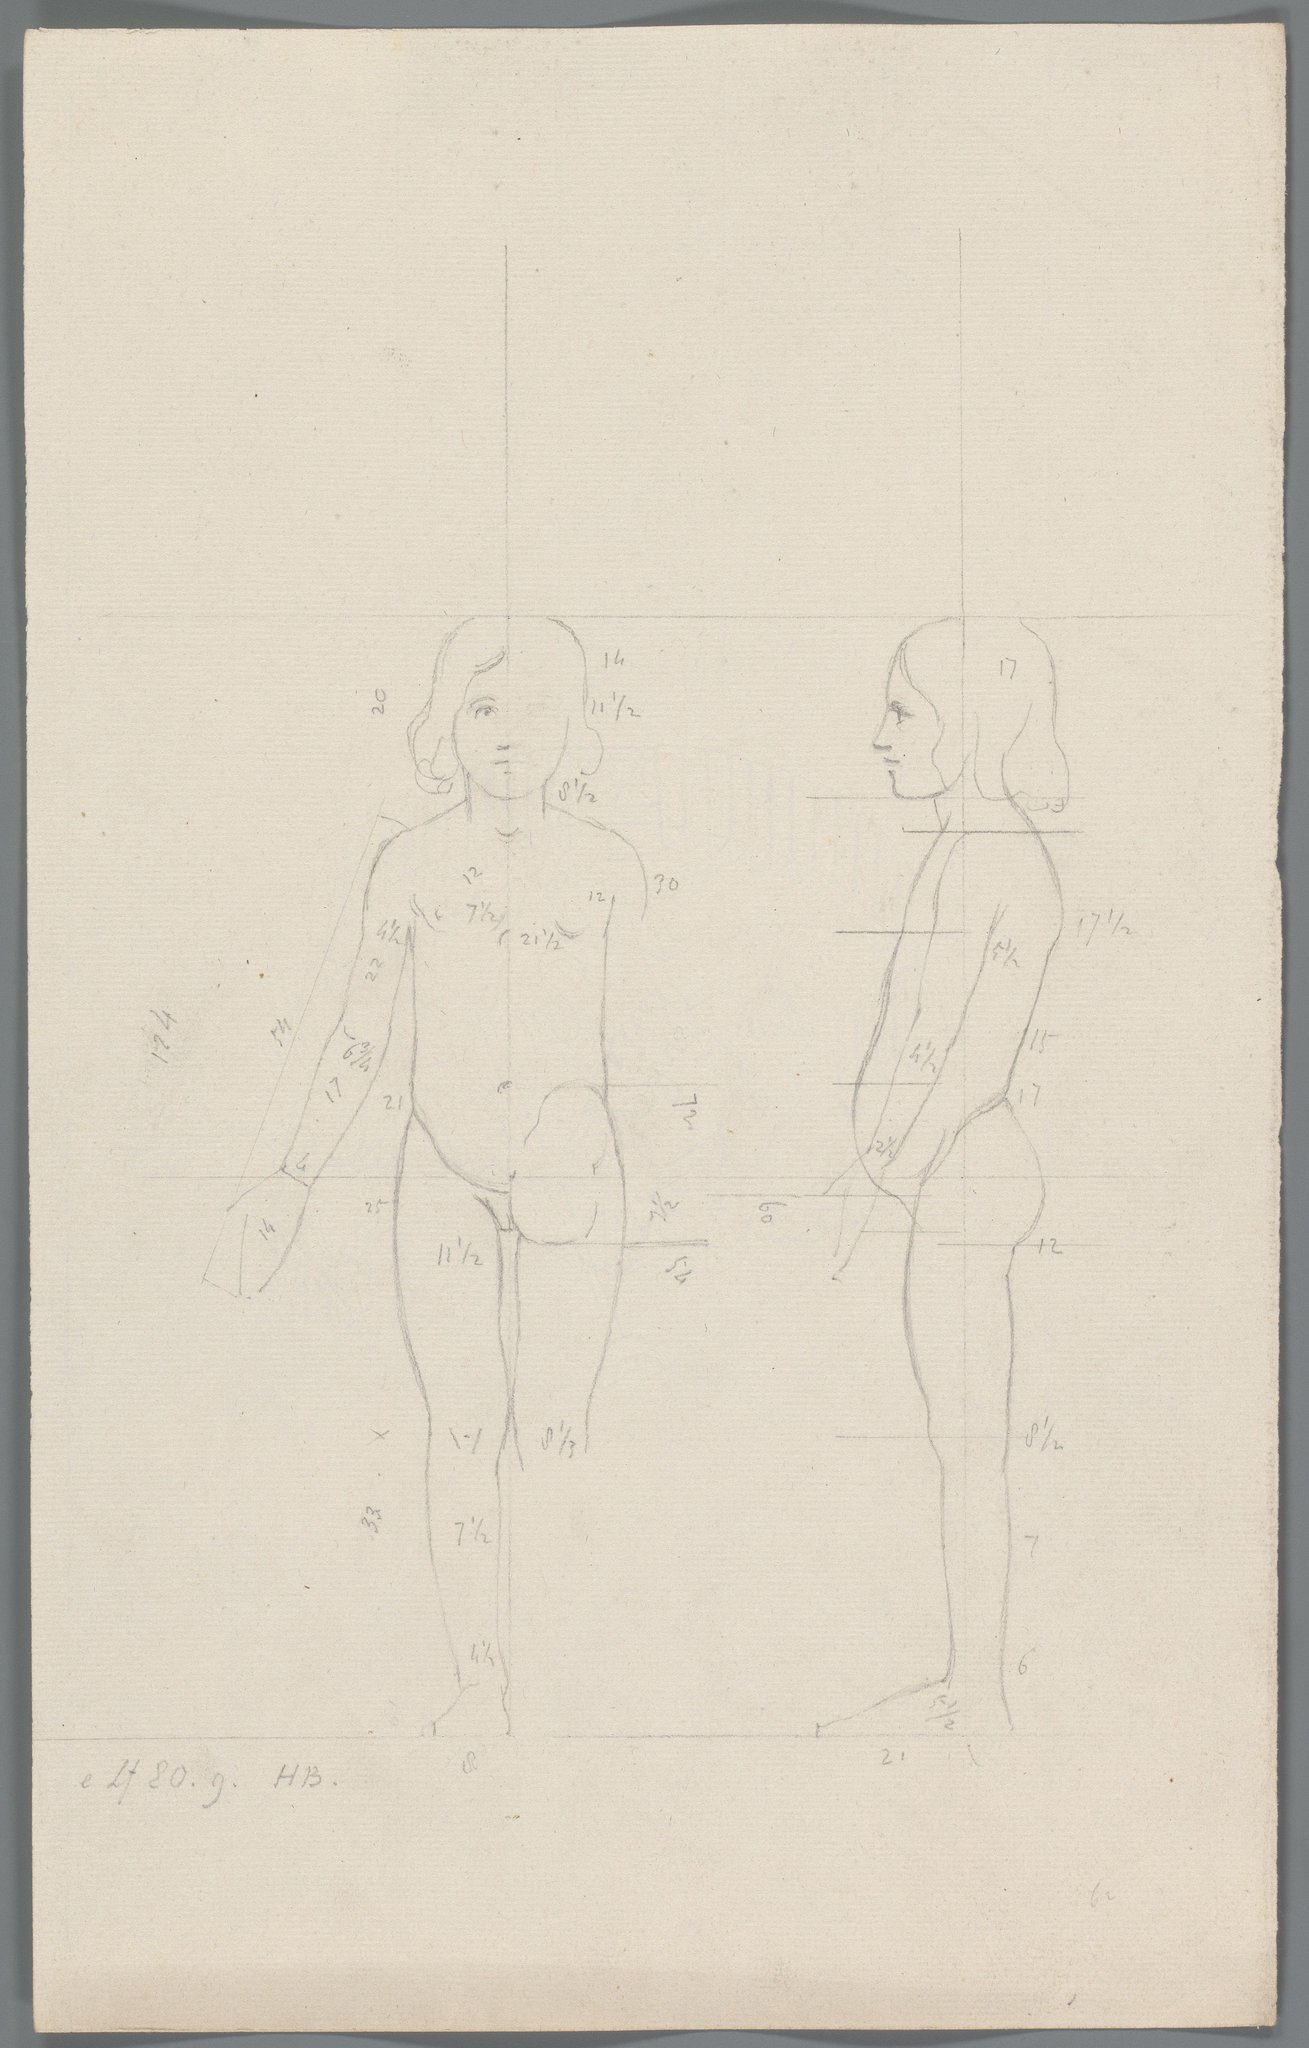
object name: drawing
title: Proportiestudie van een meisje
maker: jacobus everhardus josephus van den berg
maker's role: draughtsman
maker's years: 1802-1861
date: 1850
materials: paper, pencil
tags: standing figure (canon, proportions) - aa - female human figure, anatomy (non-medical) - aa - female human figure, child (at home) - aa - girl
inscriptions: inscription: ‘e Lf E0 g HB.’